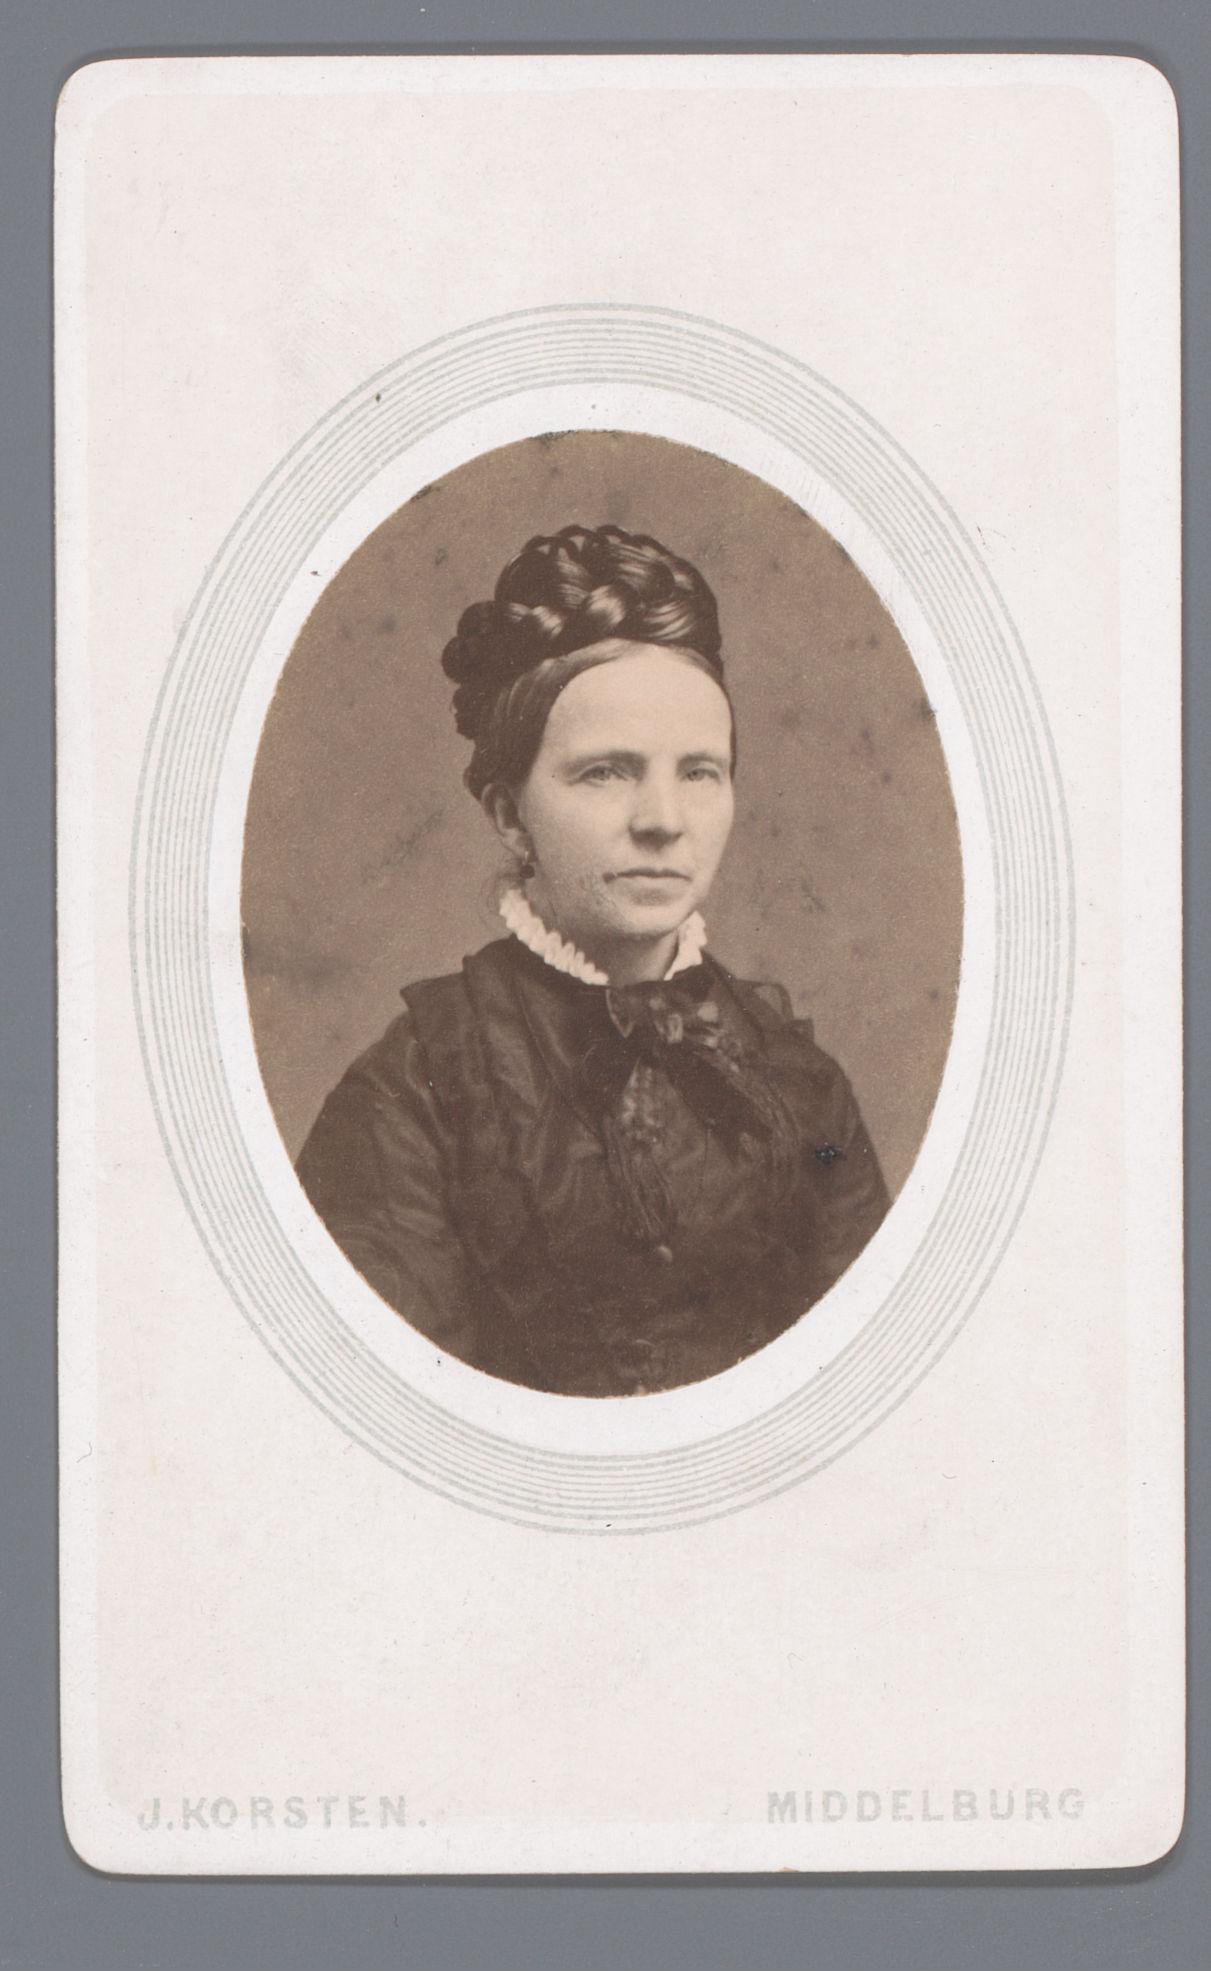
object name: carte de visite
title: Portret van een onbekende vrouw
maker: j. korsten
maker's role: fotograaf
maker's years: 1841-1878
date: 1864-1872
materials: cardboard, paper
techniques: albumen print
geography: middelburg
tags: historical persons - bb - woman